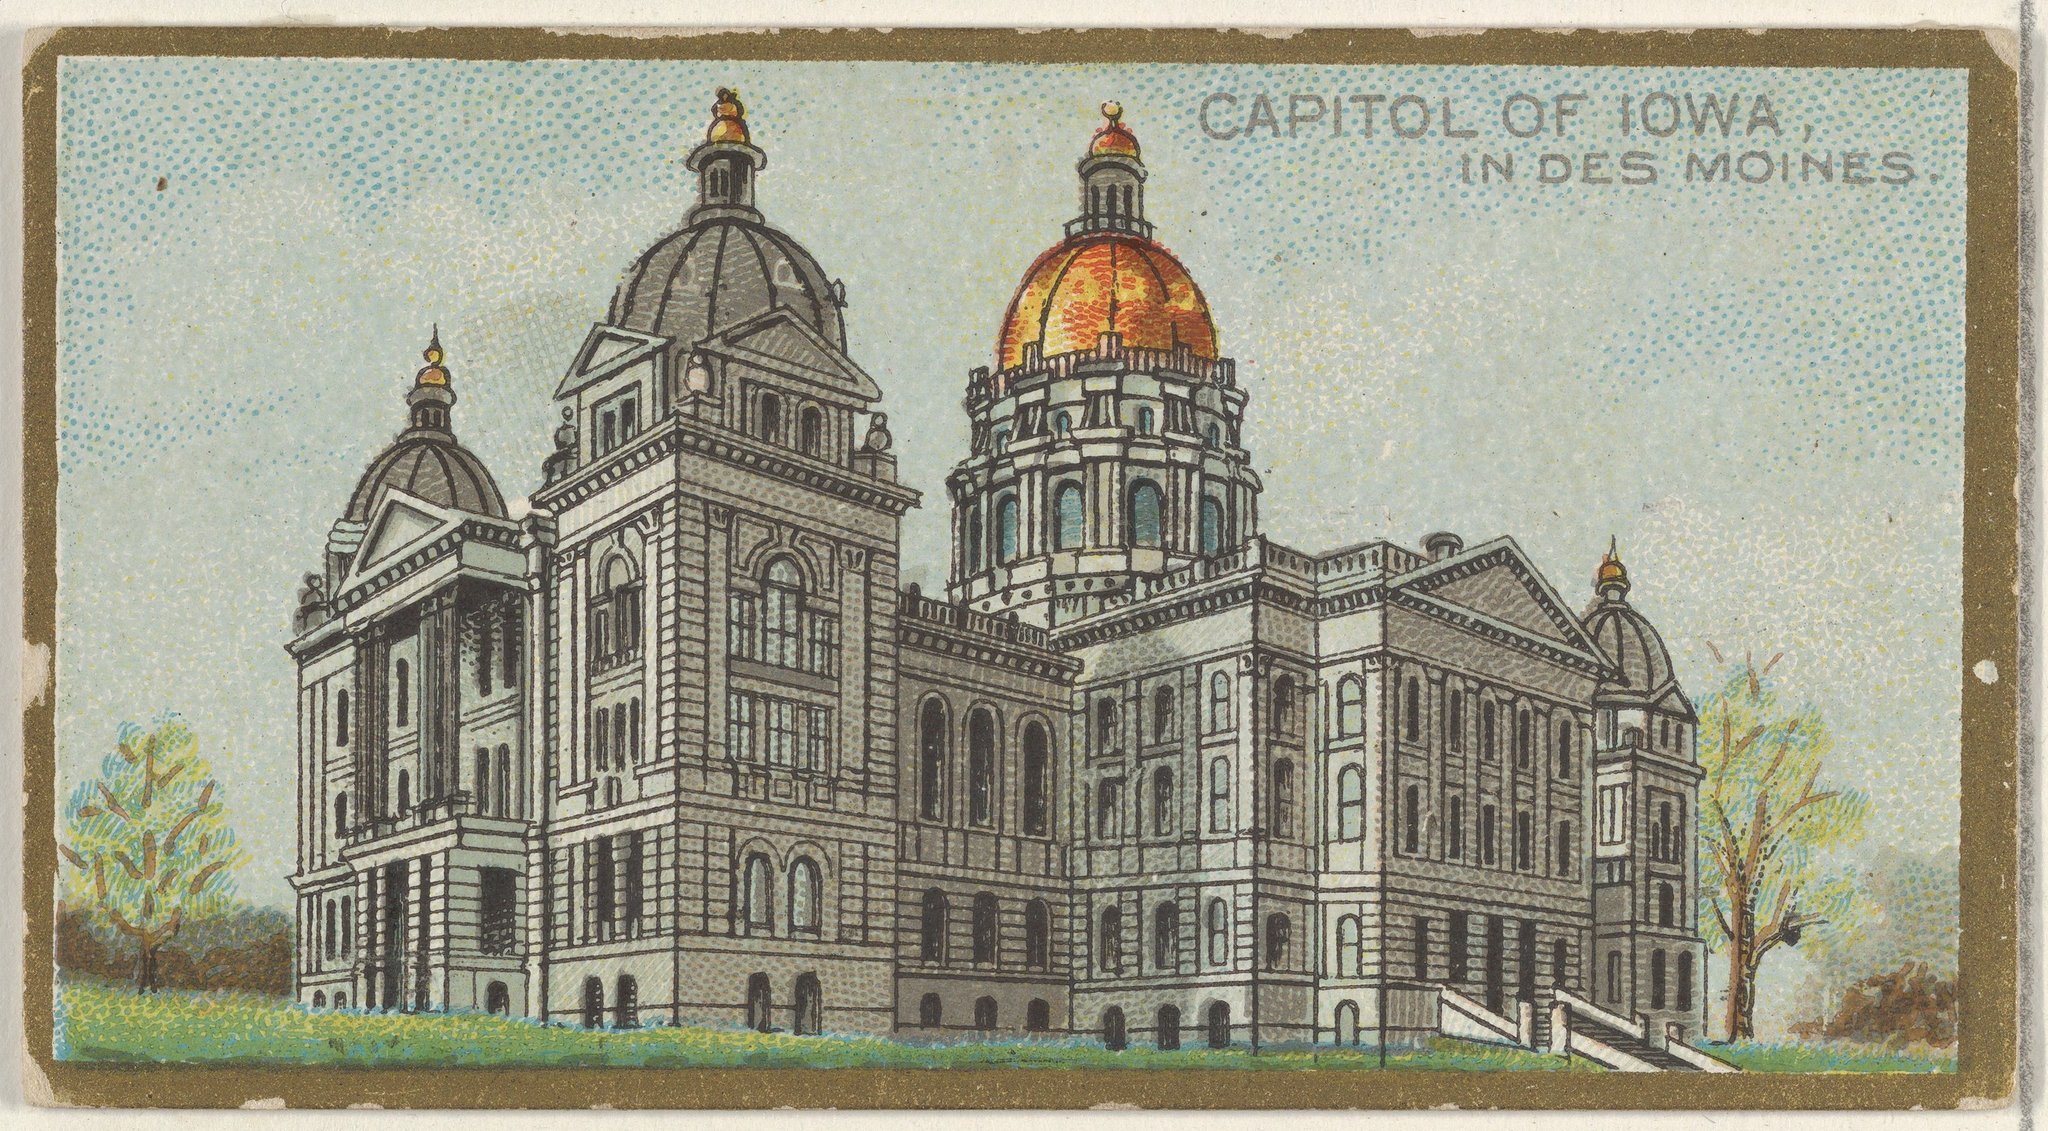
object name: print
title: Capitol of Iowa in Des Moines, from the General Government and State Capitol Buildings series (N14) for Allen & Ginter Cigarettes Brands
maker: allen & ginter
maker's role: publisher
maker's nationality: american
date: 1889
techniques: color lithograph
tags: buildings